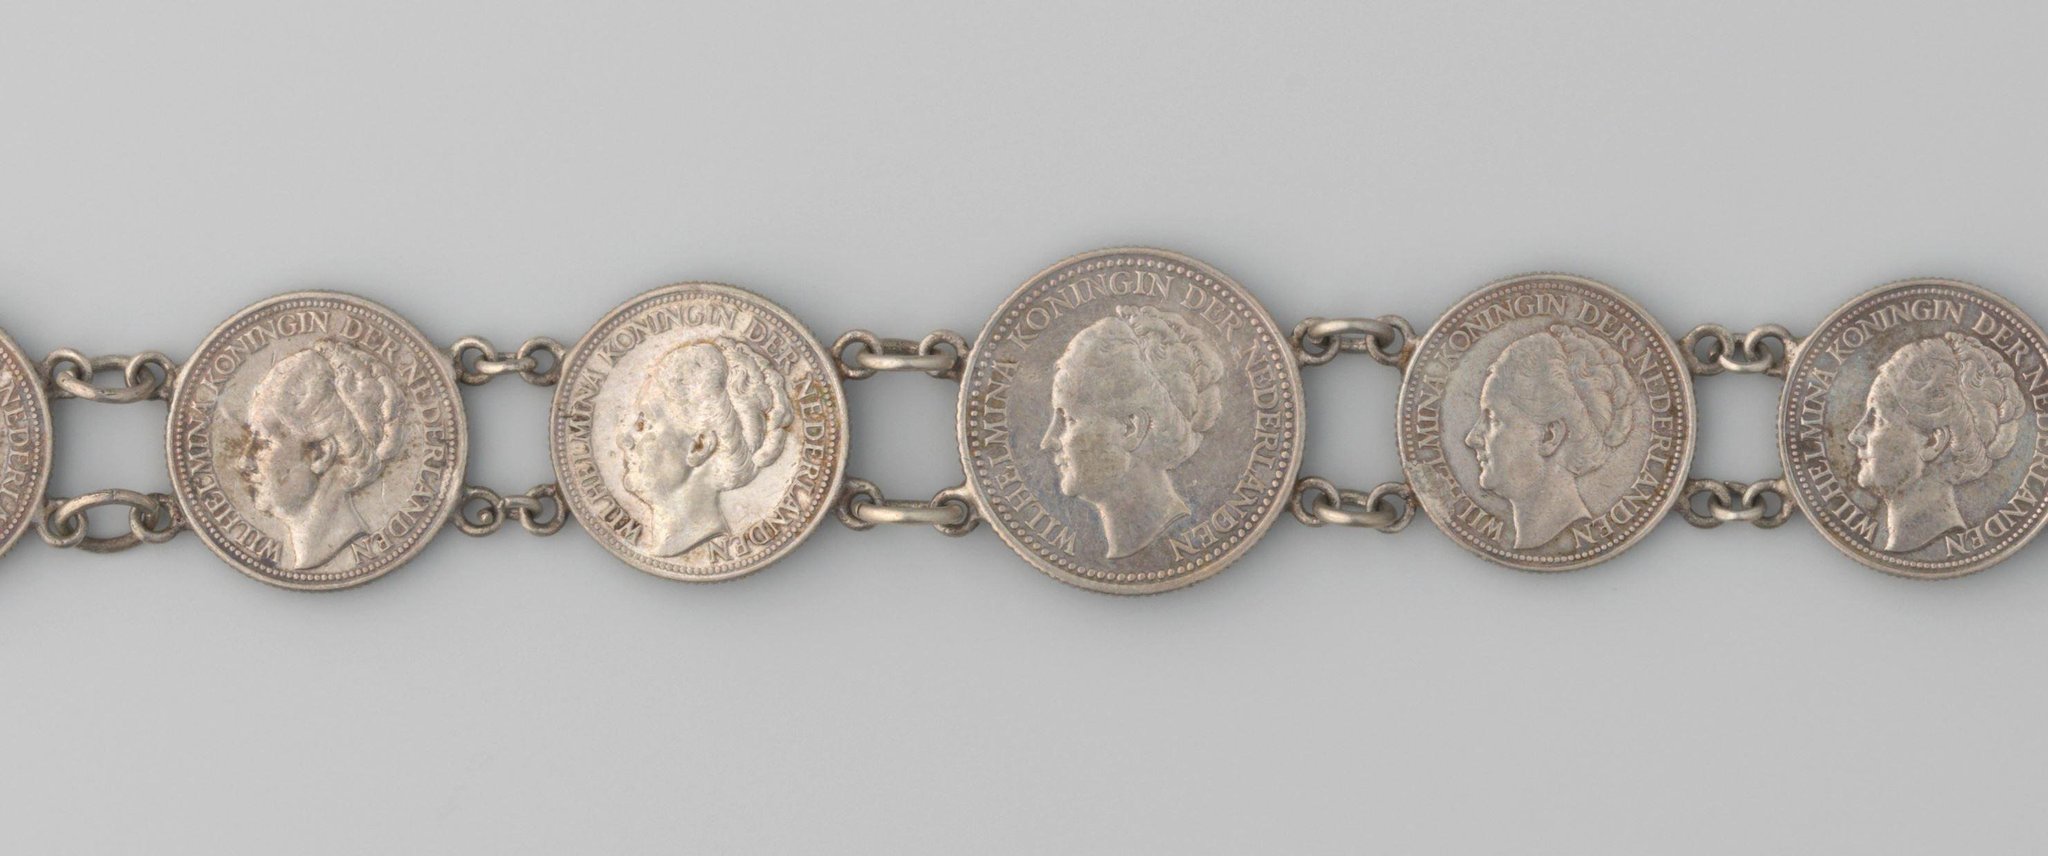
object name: bracelet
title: Zilveren armband van acht Nederlandse munten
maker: Anonymous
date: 1940-1950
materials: silver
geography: netherlands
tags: the hague, print maker, wilhelmina of the netherlands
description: Zilveren armband van negen Nederlandse munten met de beeldenaar van Wilhelmina voorzien van een baksluiting. Één halve gulden en zeven kwartjes. De baksluiting is gemaakt van een kwartje. Niet gekeurd.